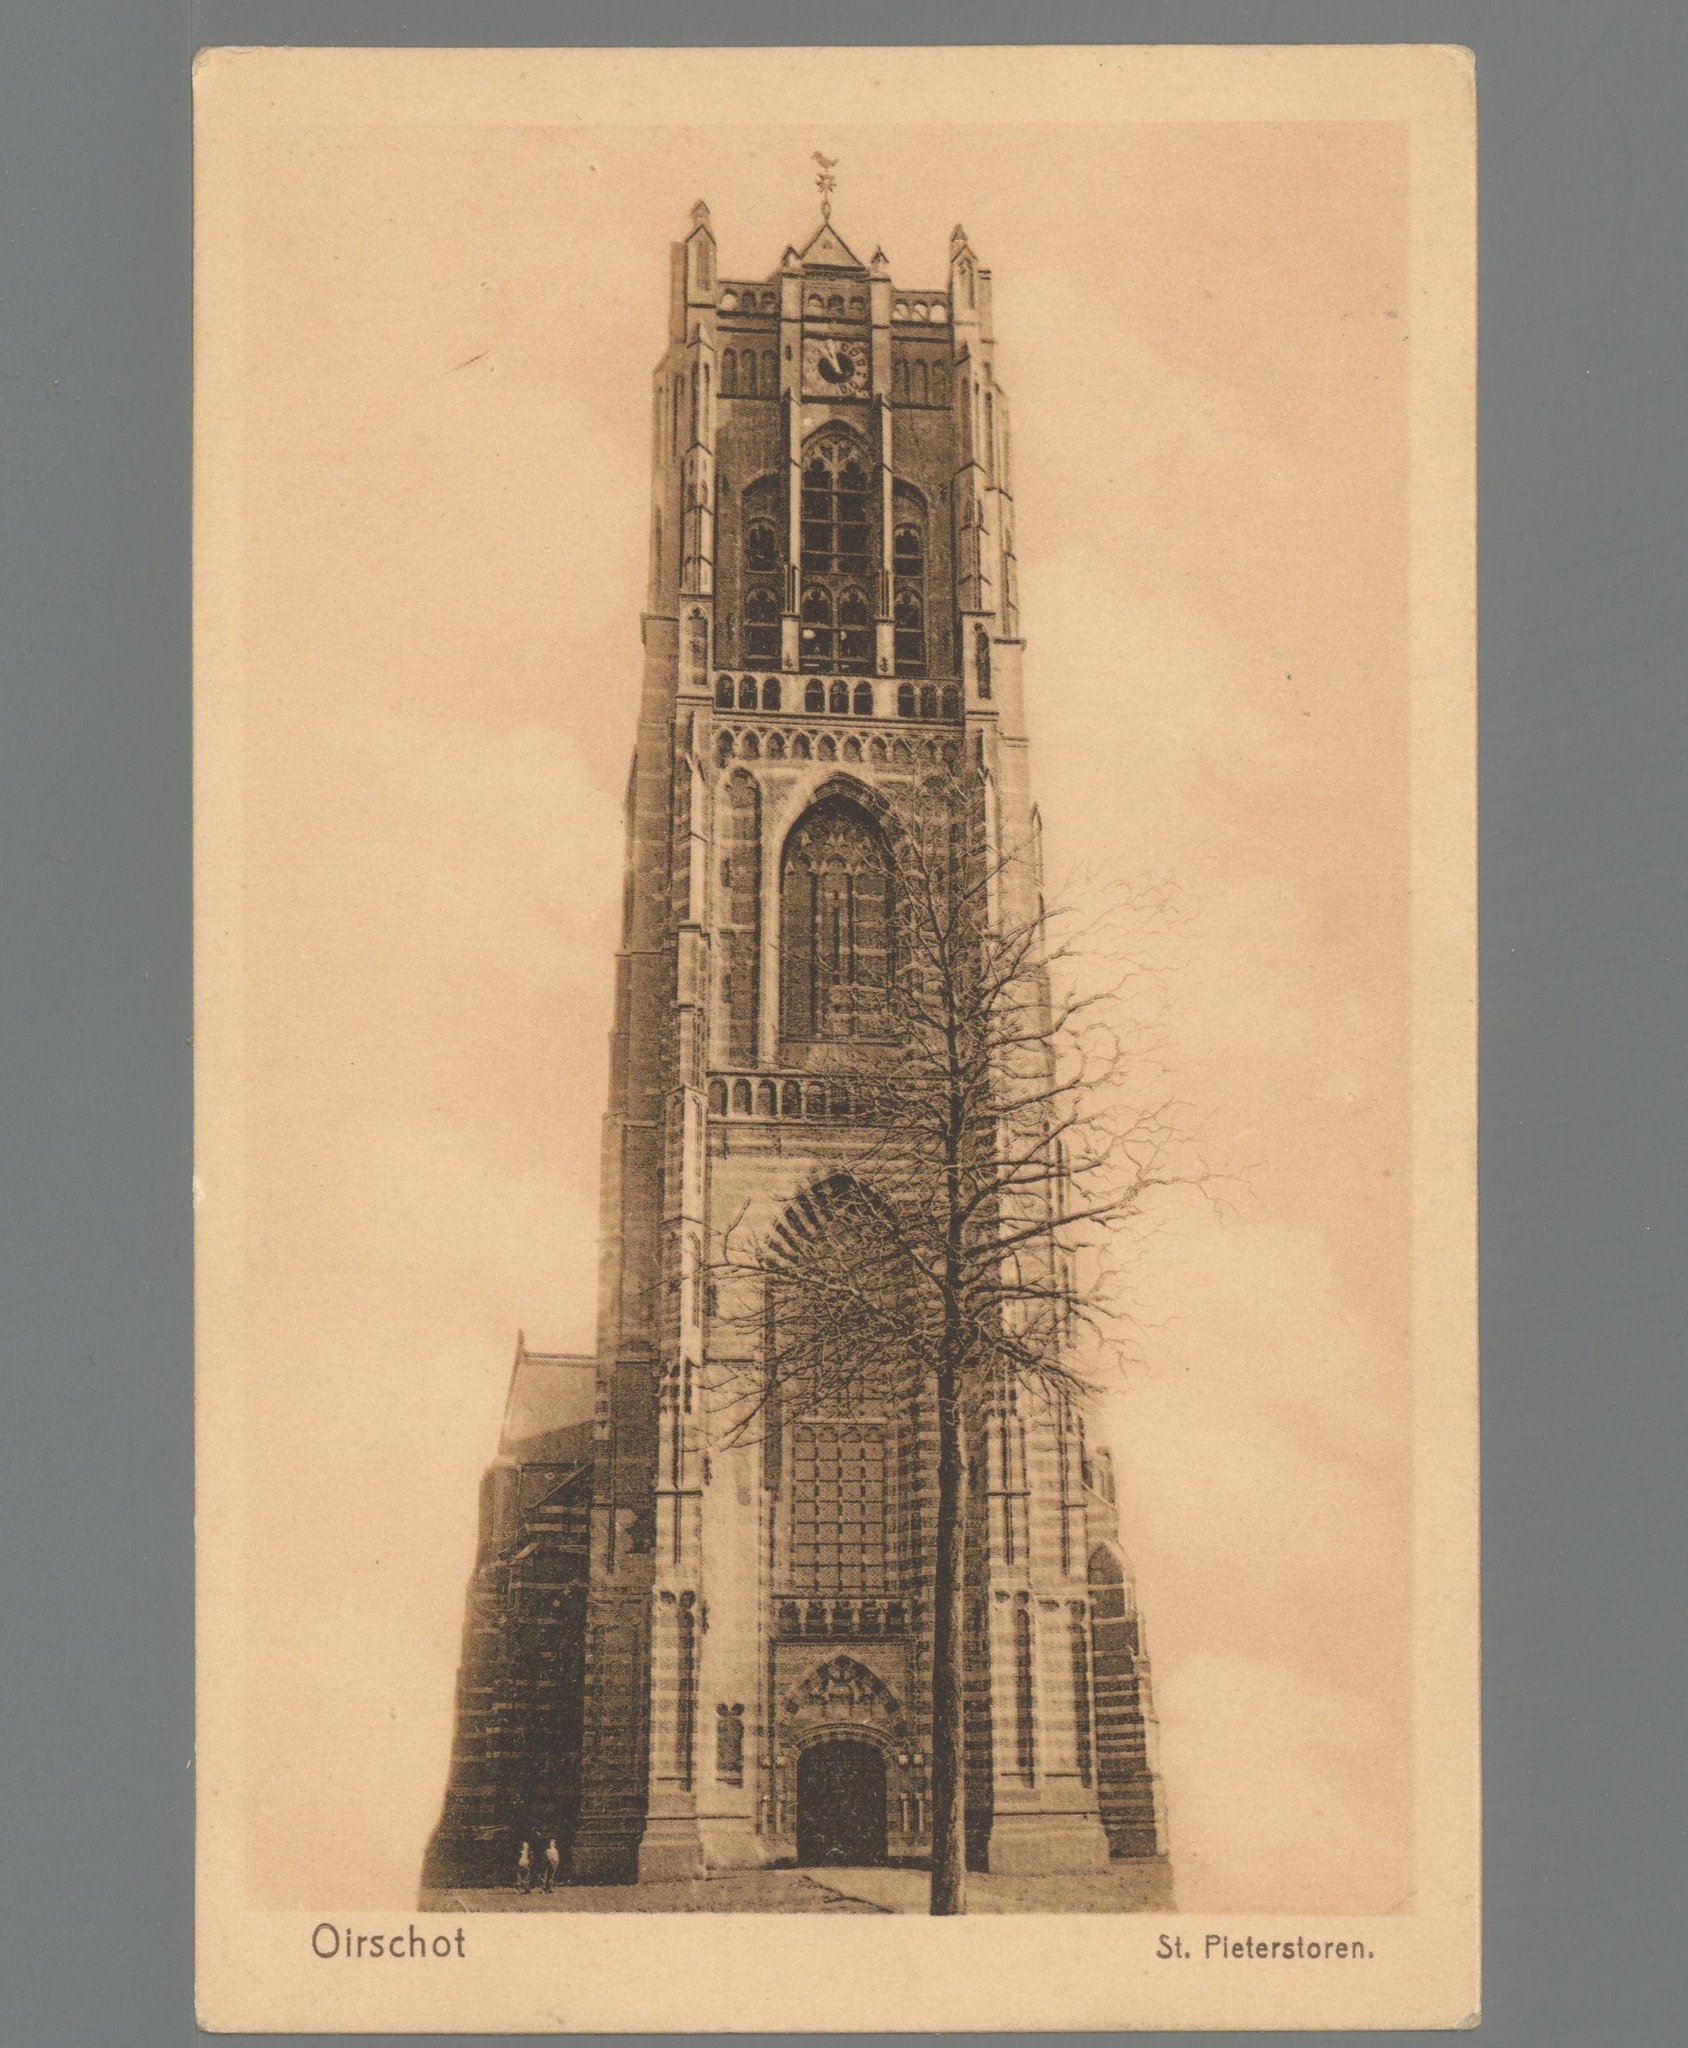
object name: ansichtkaart, prentbriefkaart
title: Oirschot. St. Pieterstoren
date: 1913-1950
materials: cardboard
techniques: photograph, writing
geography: oirschot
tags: church (exterior)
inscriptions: poststempel, verso, gestempeld